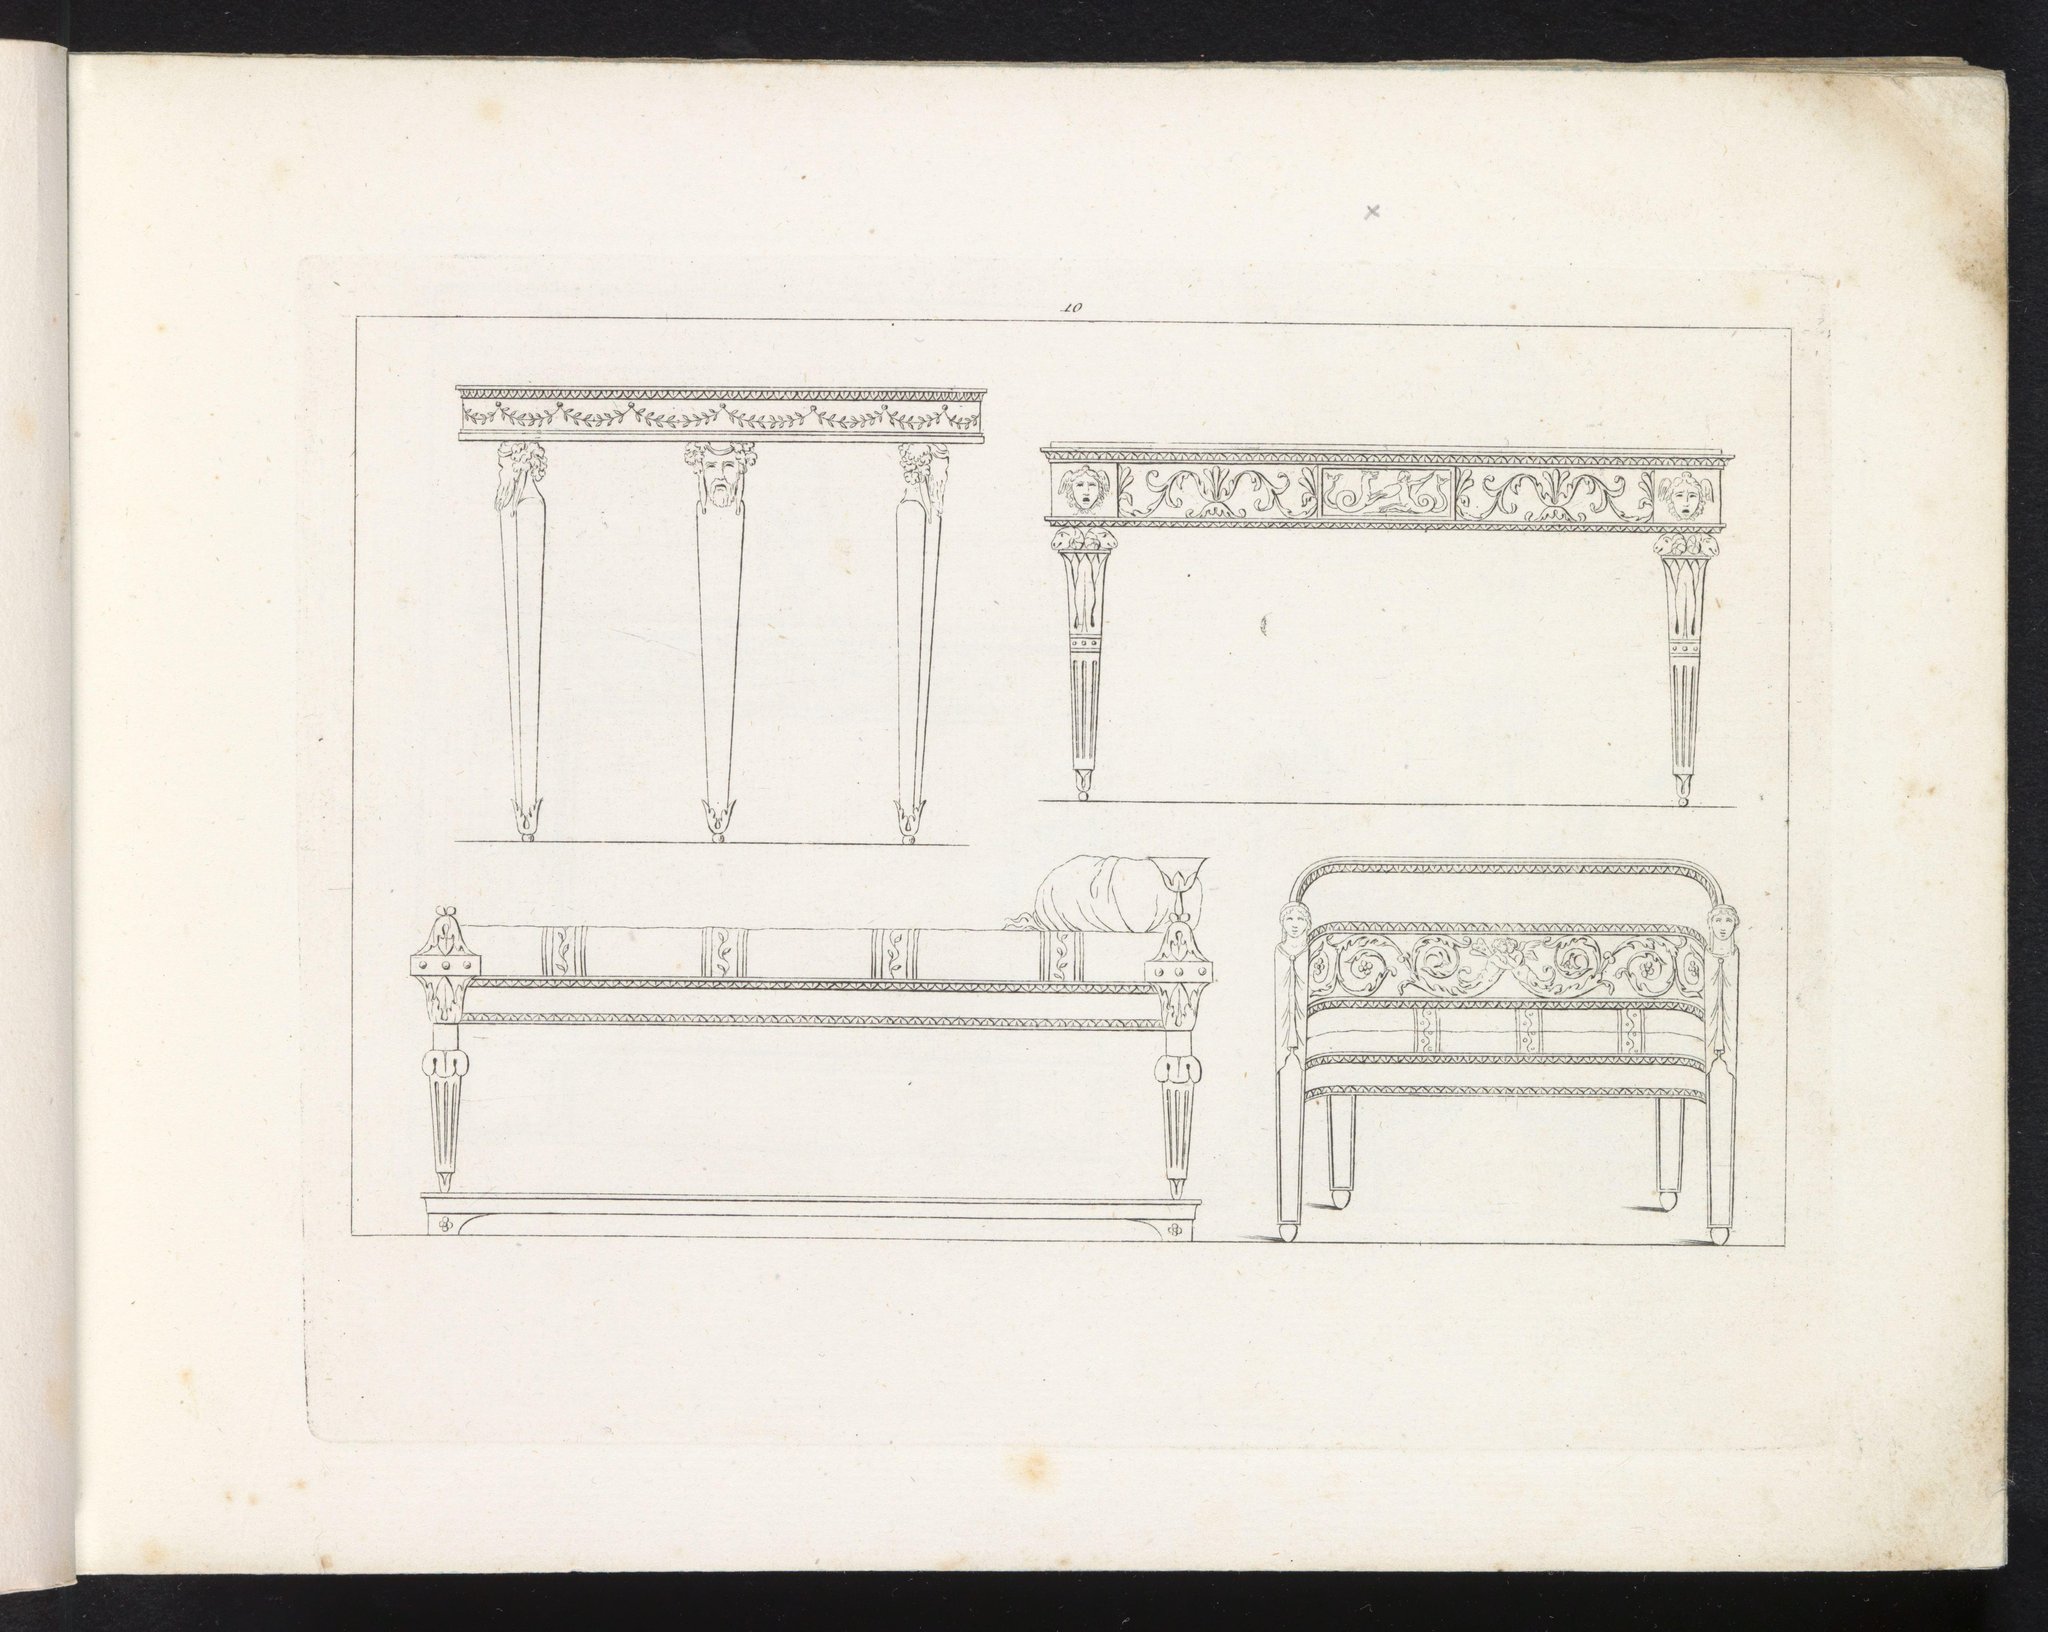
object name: print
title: Invenzioni diverse di mobili ed utensili sacri e profani per usi comuni della vita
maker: pietro ruga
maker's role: print maker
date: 1817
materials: paper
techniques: etching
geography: italy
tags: bench, ornaments ~ art, table, bed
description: Prent maakt deel uit van een reeks van 100 prenten (+ titelprent) met ontwerpen voor religieuze en profane voorwerpen.